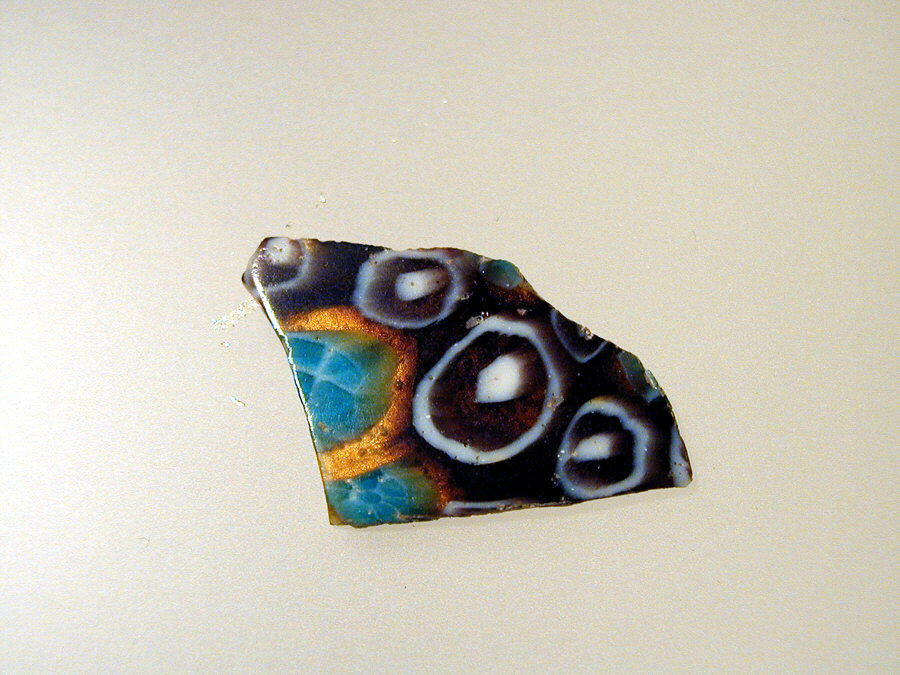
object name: fragment, mosaic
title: Glass mosaic fragment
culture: roman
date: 34 BCE-33 CE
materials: glass